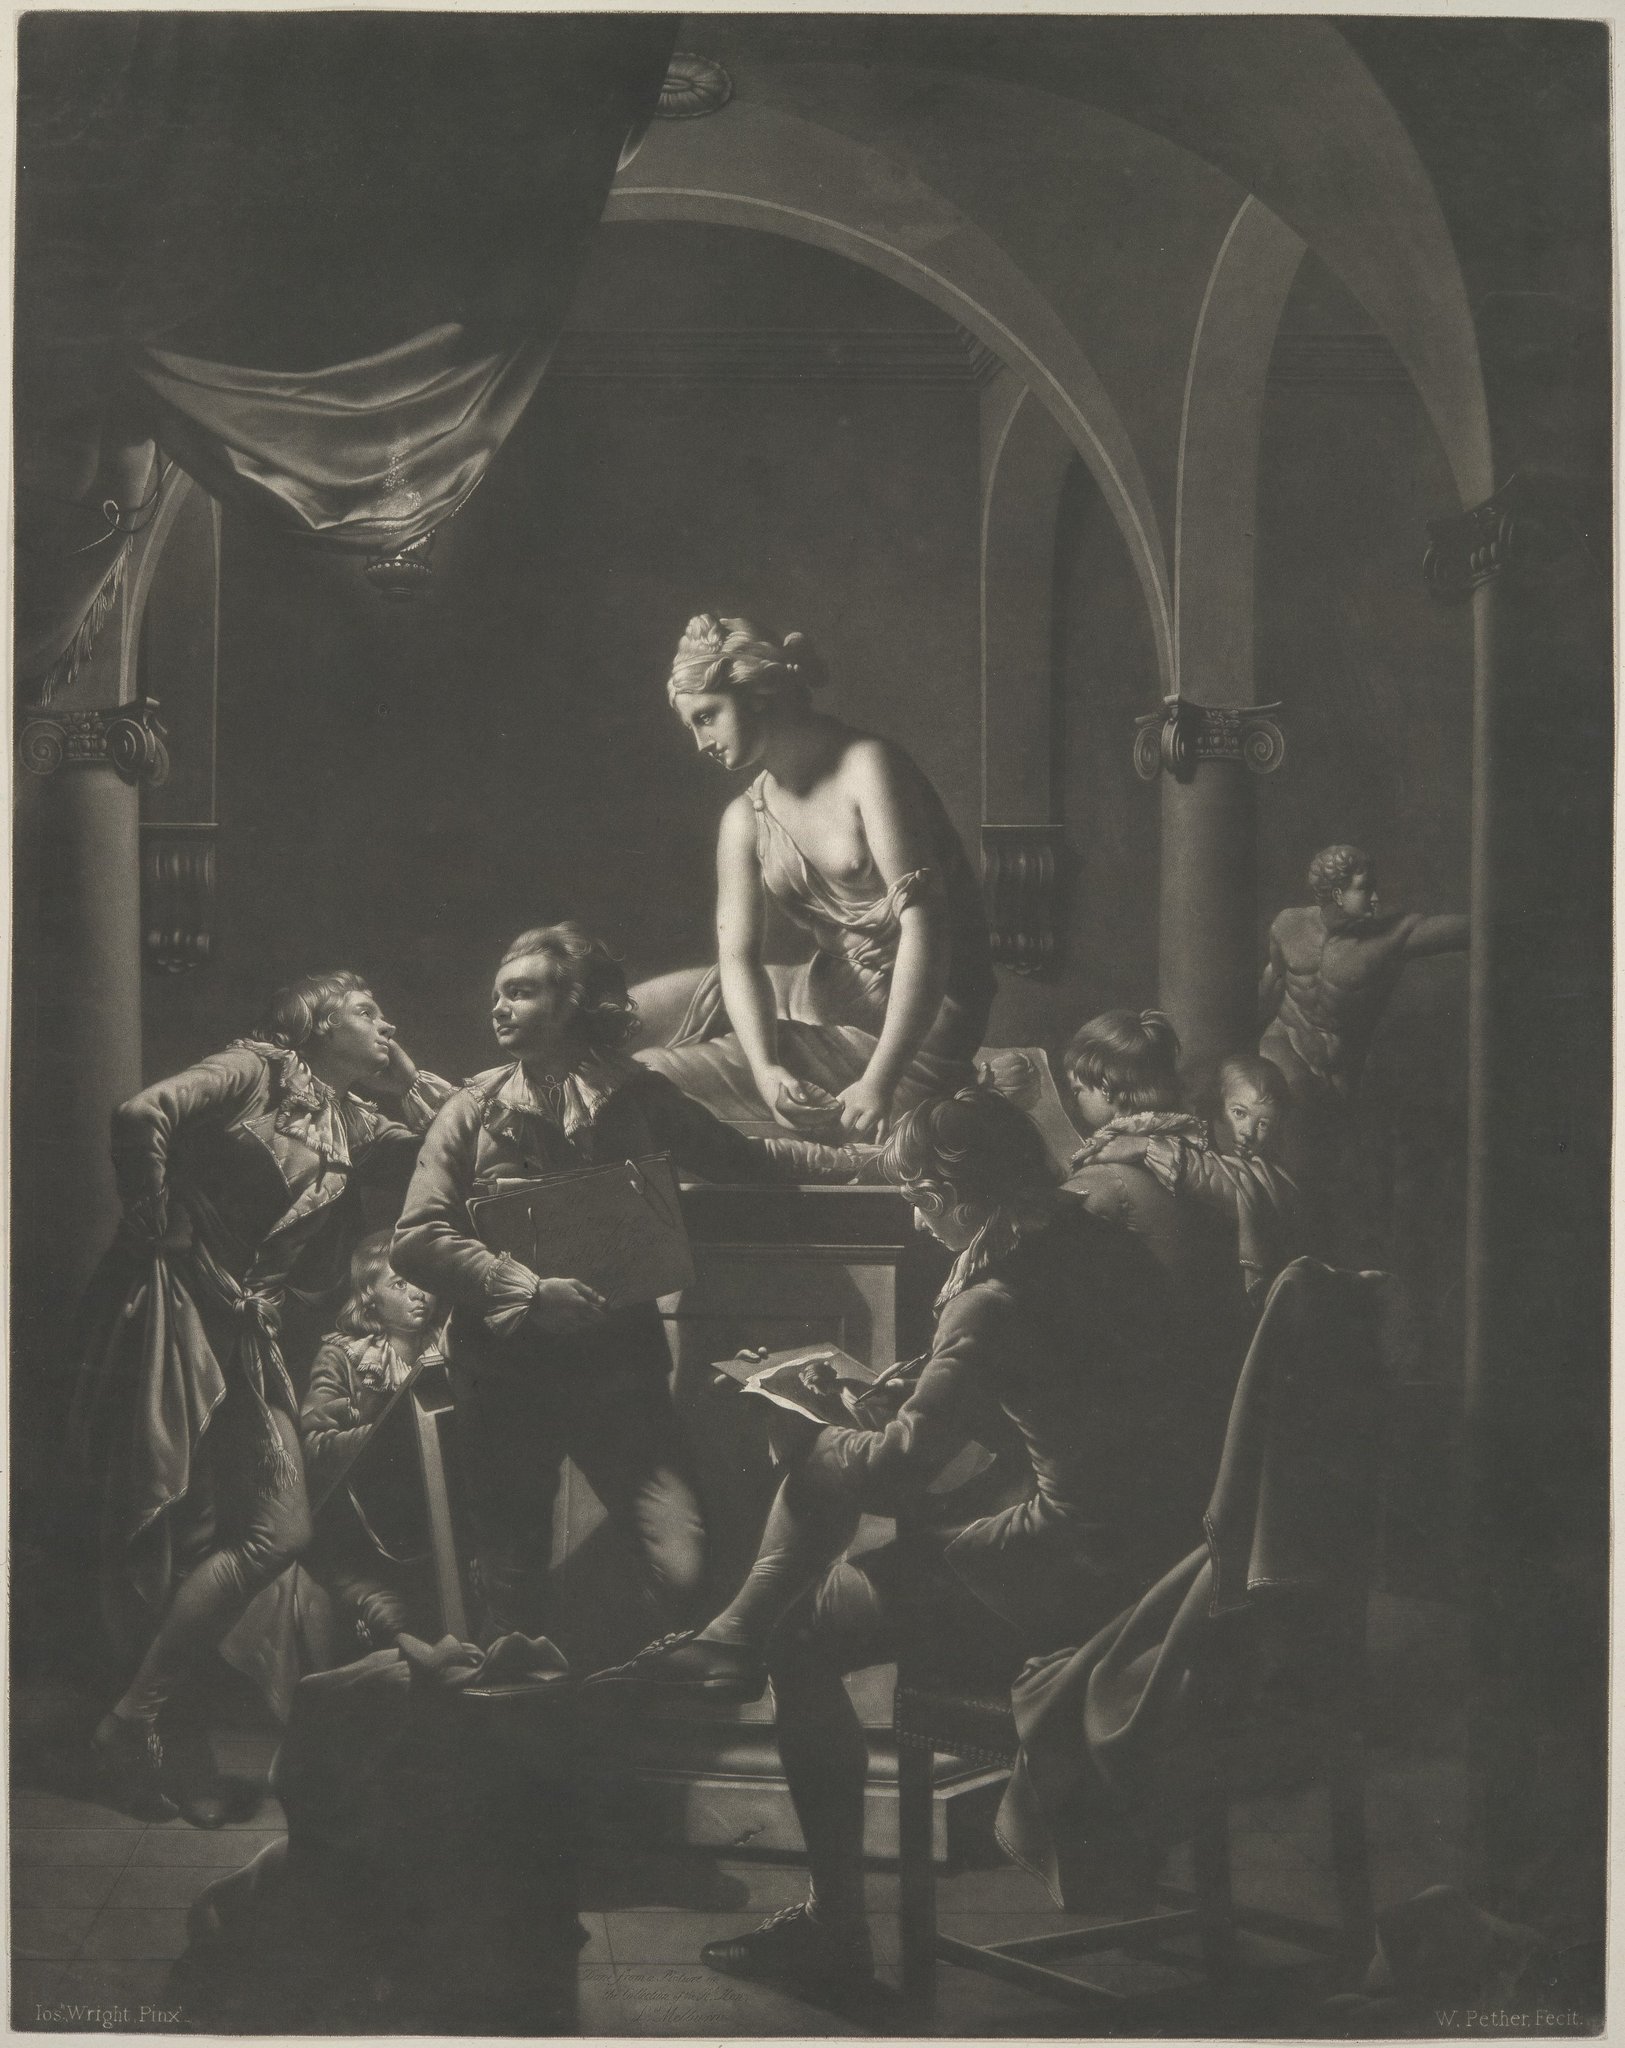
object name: print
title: An Academy by Lamplight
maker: william pether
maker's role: engraver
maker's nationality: british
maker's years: 1733-1821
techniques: mezzotint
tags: painting,sculpture,men,female nudes